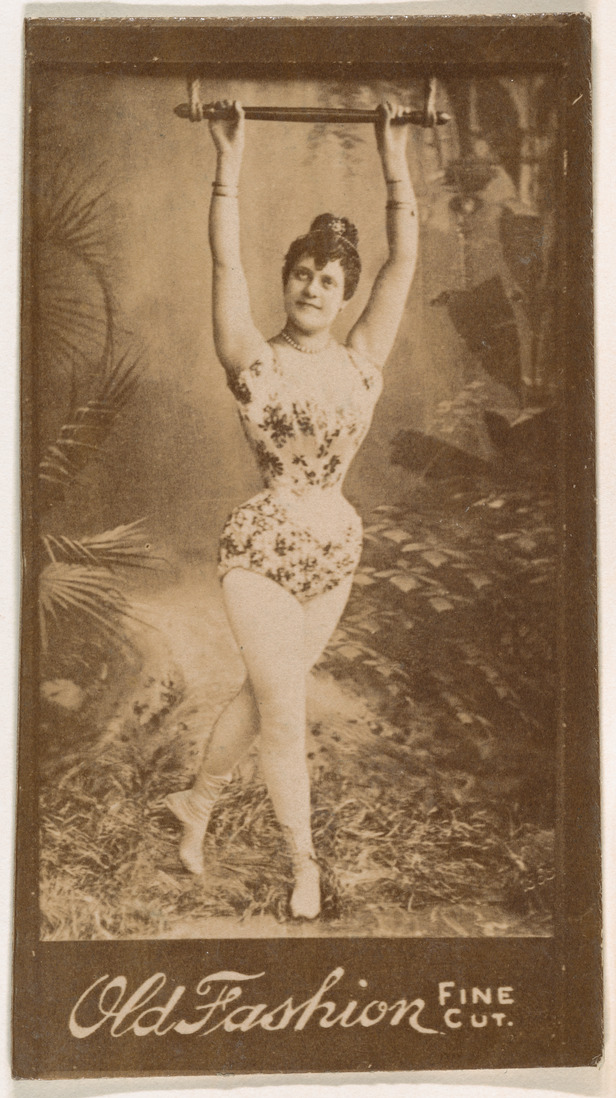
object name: photograph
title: Actress holding onto metal bar above head, from the Actresses series (N664) promoting Old Fashion Fine Cut Tobacco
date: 1888-1890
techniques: albumen silver print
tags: portraits,women,actresses